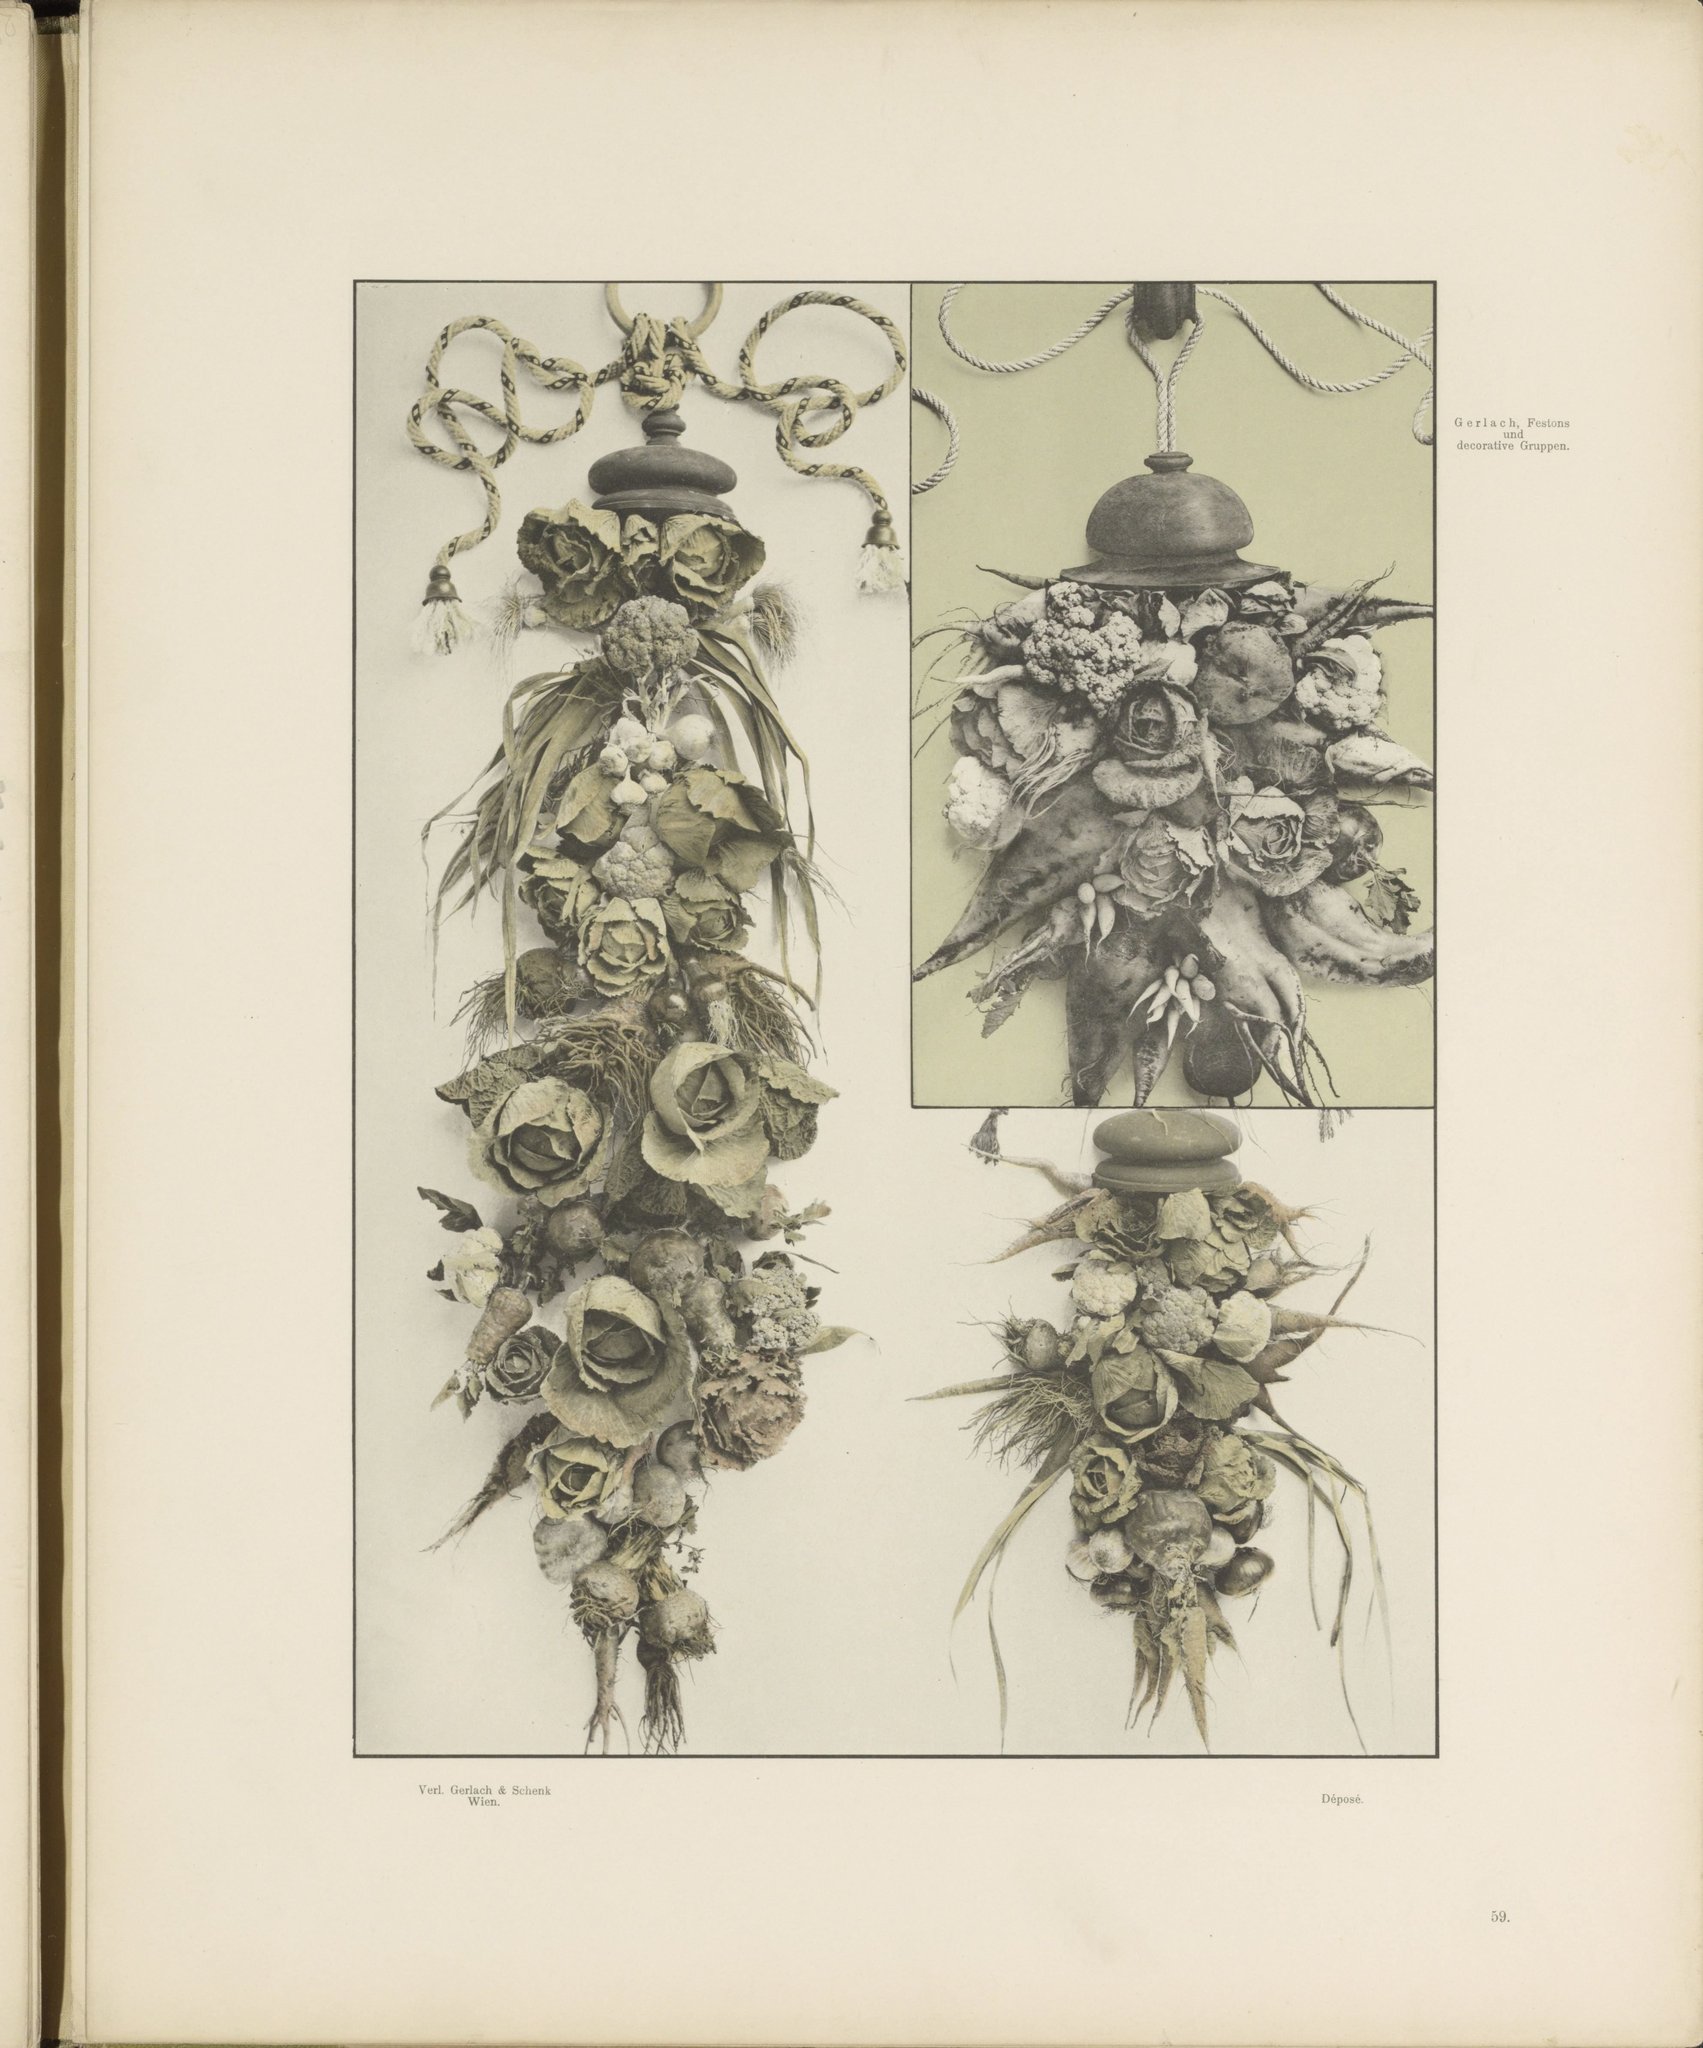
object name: photomechanical print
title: Festoenen van groente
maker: Anonymous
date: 1887-1897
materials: paper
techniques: photograph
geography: vienna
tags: vegetables, ornament ~ festoon, garland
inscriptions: number: ‘59.’